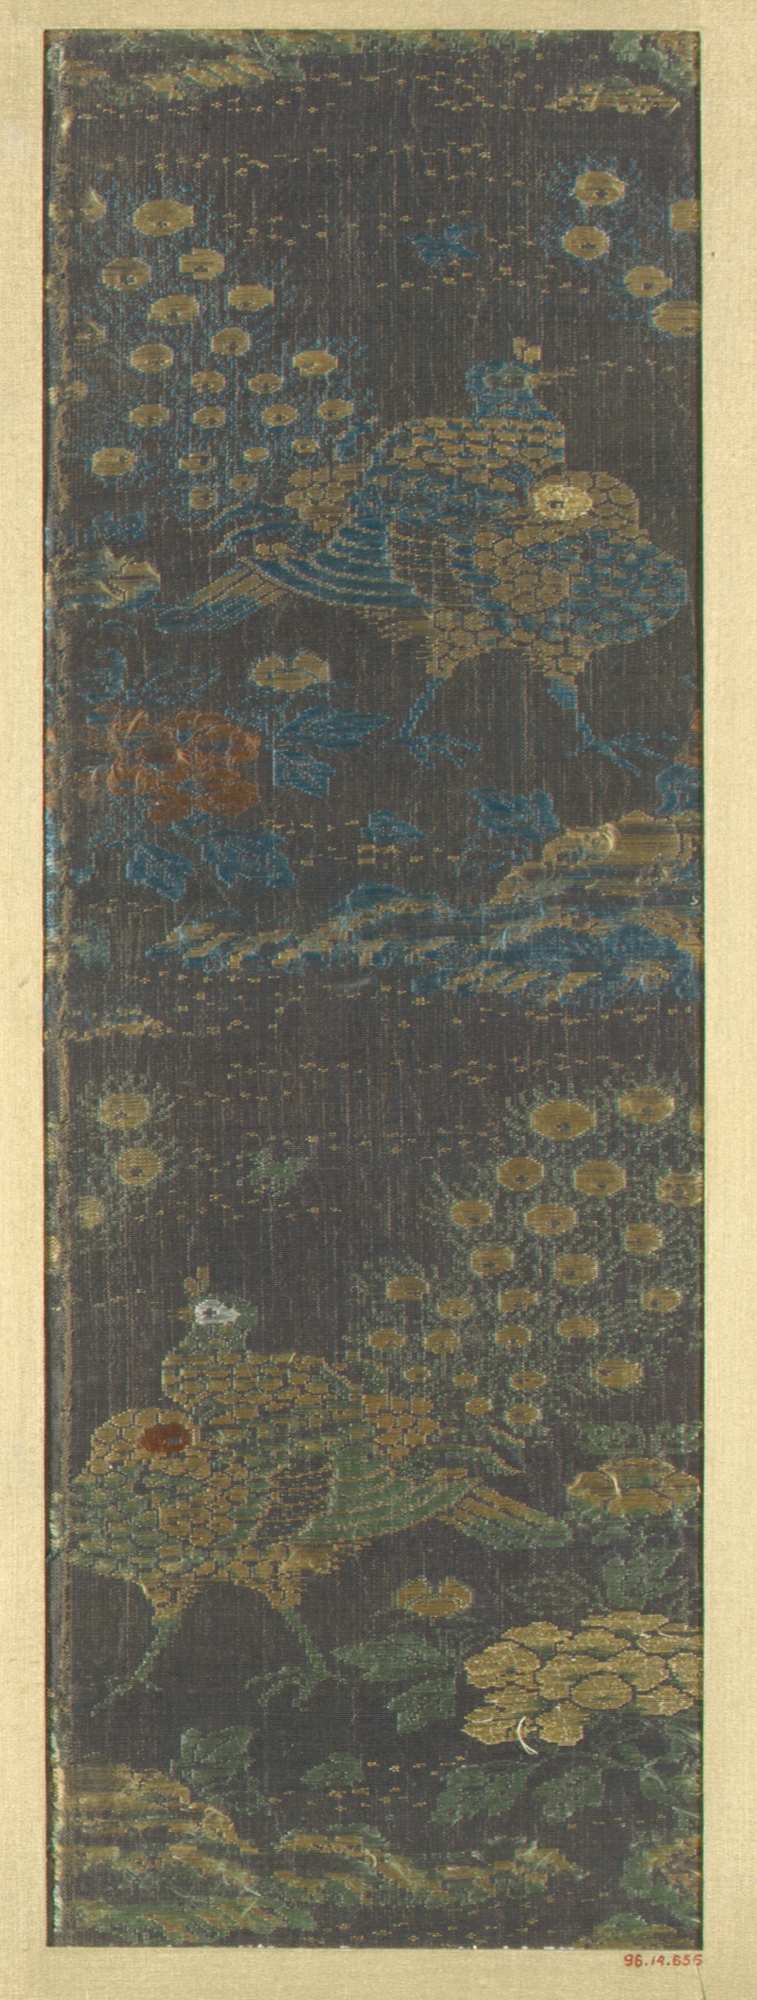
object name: piece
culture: japanese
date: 1701-1900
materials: silk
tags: peacocks